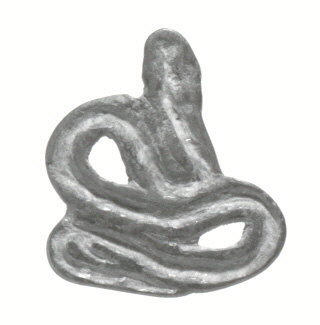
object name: stamp seal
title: Compartmented stamp seal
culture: bactria-margiana archaeological complex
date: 2333-1668 BCE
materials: copper alloy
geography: bactria-margiana